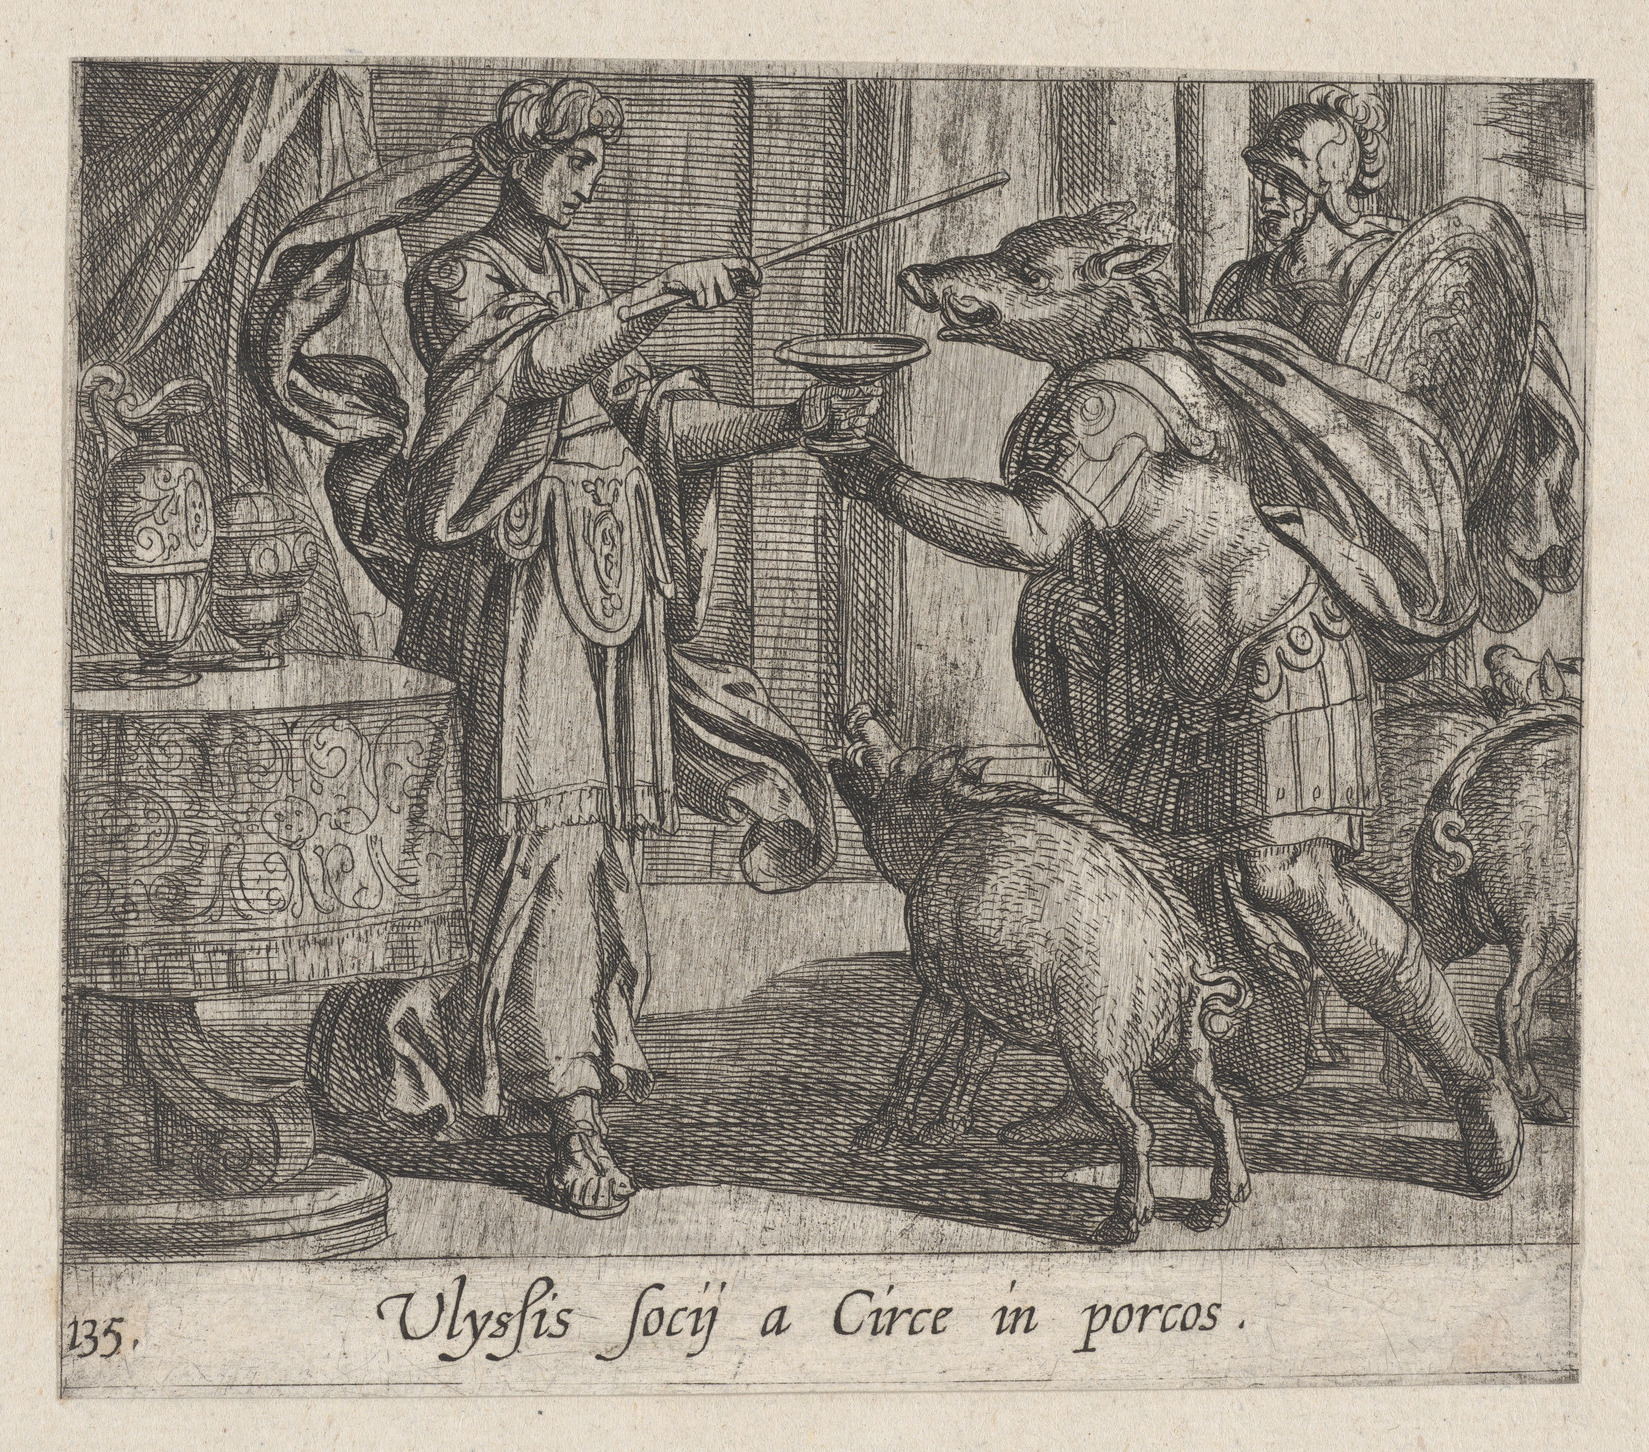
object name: print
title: Plate 135: Circe Changing Ulysses' Men into Swine (Ulyssis soci a Circe in porcos), from Ovid's 'Metamorphoses'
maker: antonio tempesta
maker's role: artist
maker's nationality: italian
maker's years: 1555-1630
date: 1606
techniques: etching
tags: men,women,pigs